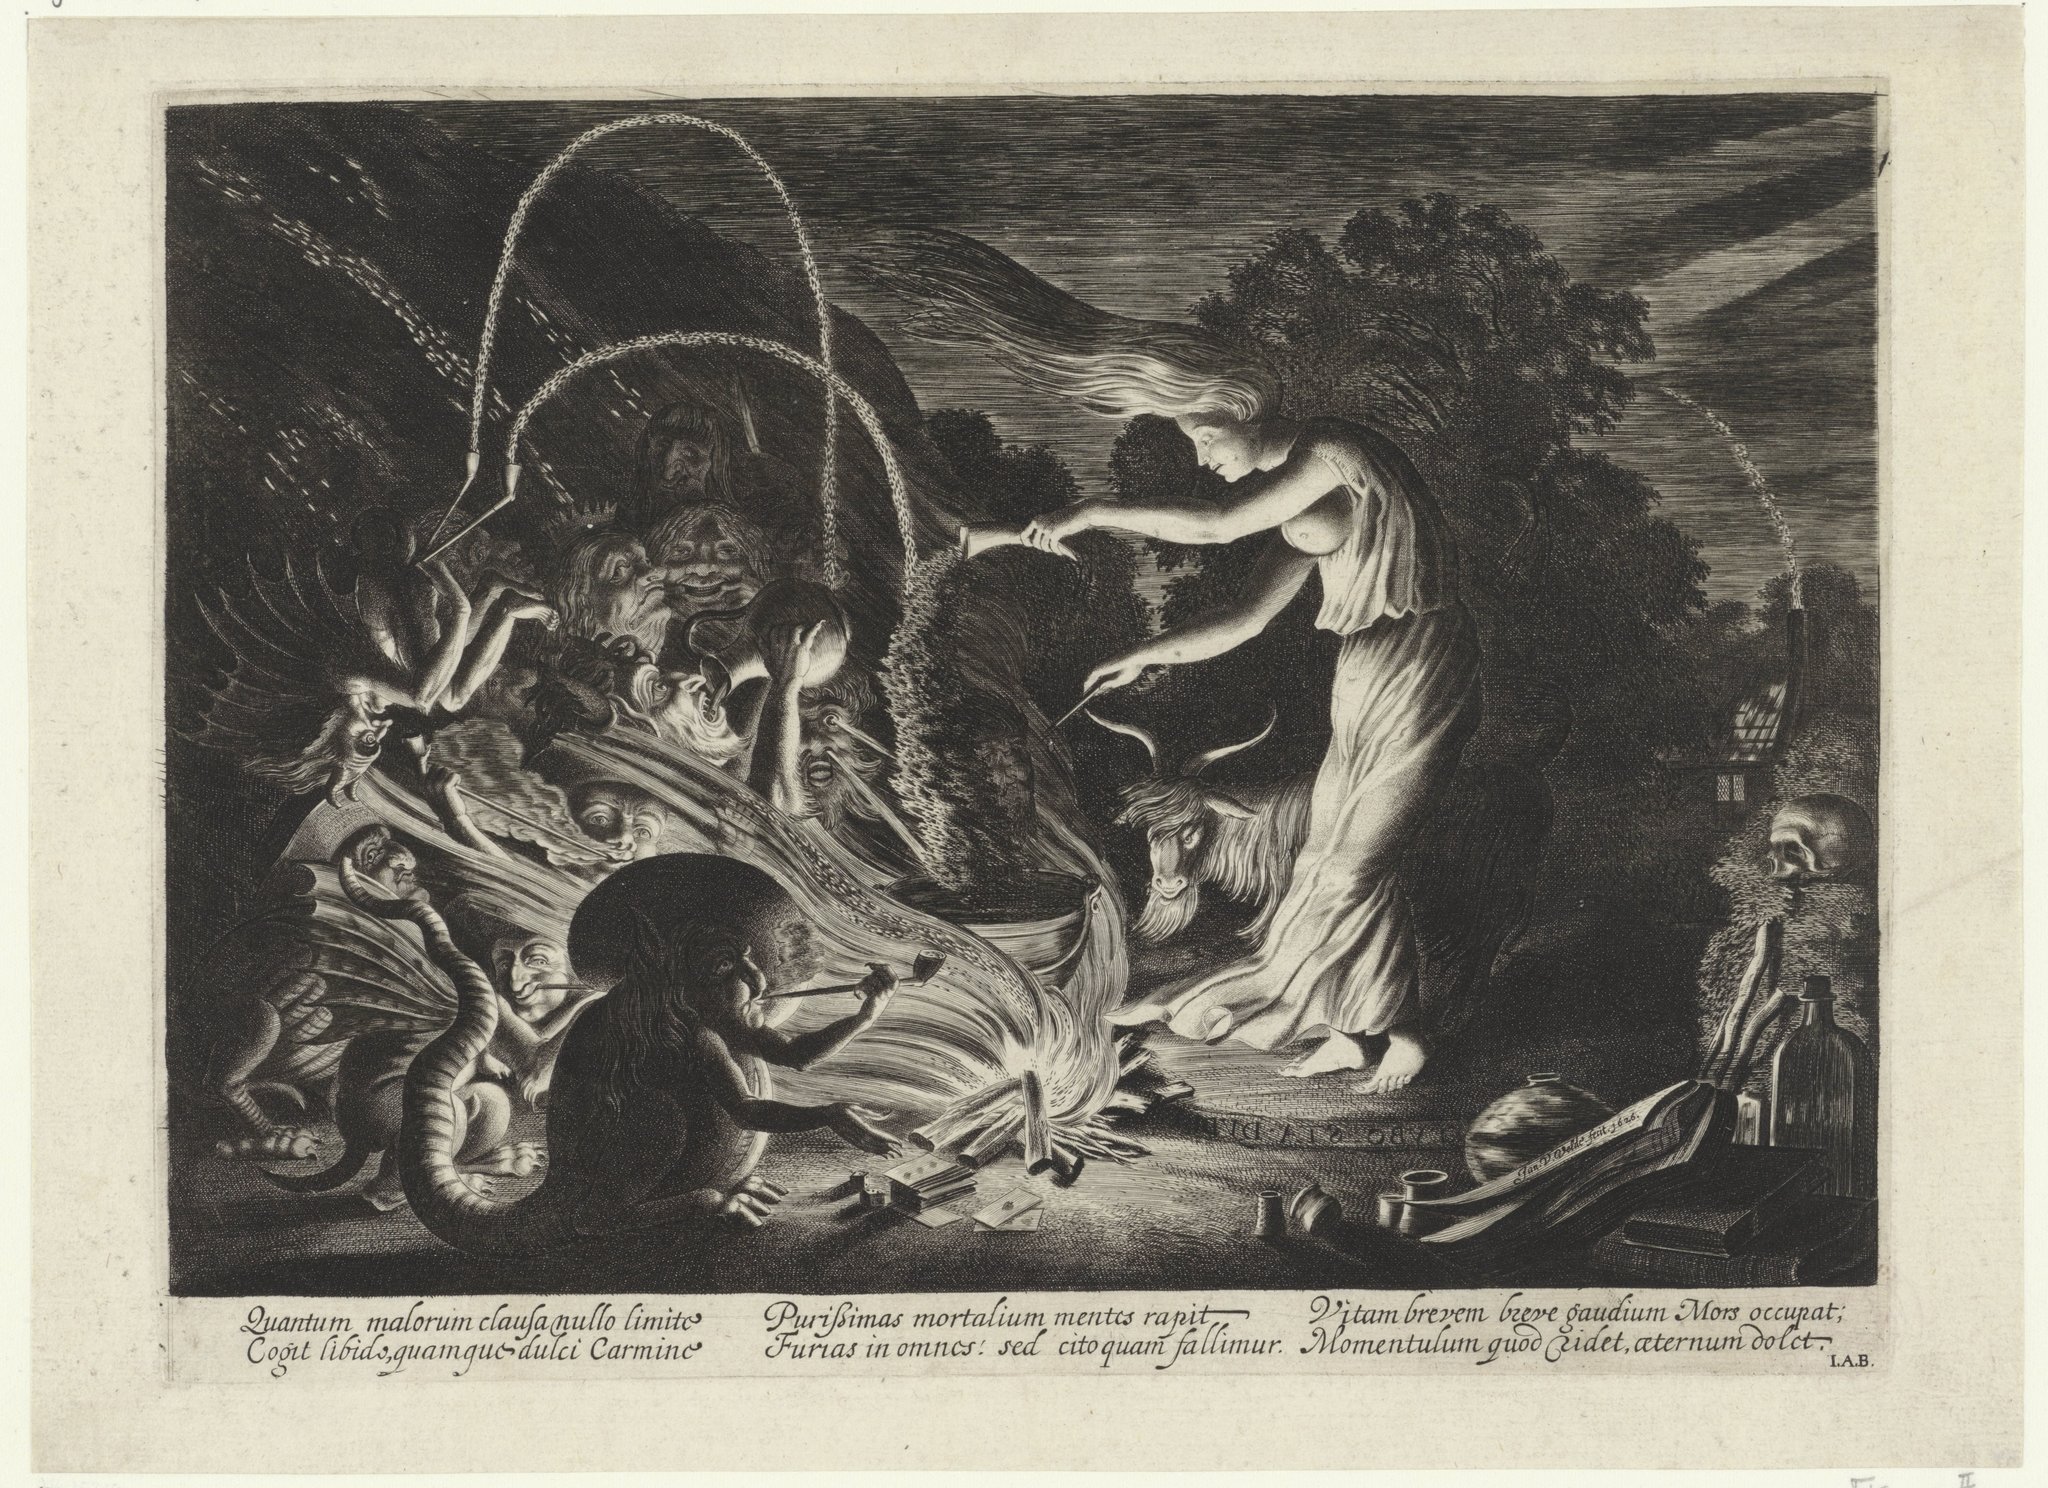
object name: print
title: Heks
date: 1626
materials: paper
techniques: engraving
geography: amsterdam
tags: witches controlling the elements, e.g. raising a storm, witch, sorcerer with the devil and/or demons, witch, sorceress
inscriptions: collector's mark: Lugt 240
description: Een heks bij een kookpot waar zij poeders in giet. Er waait een harde wind. Voor haar een groep monsters.